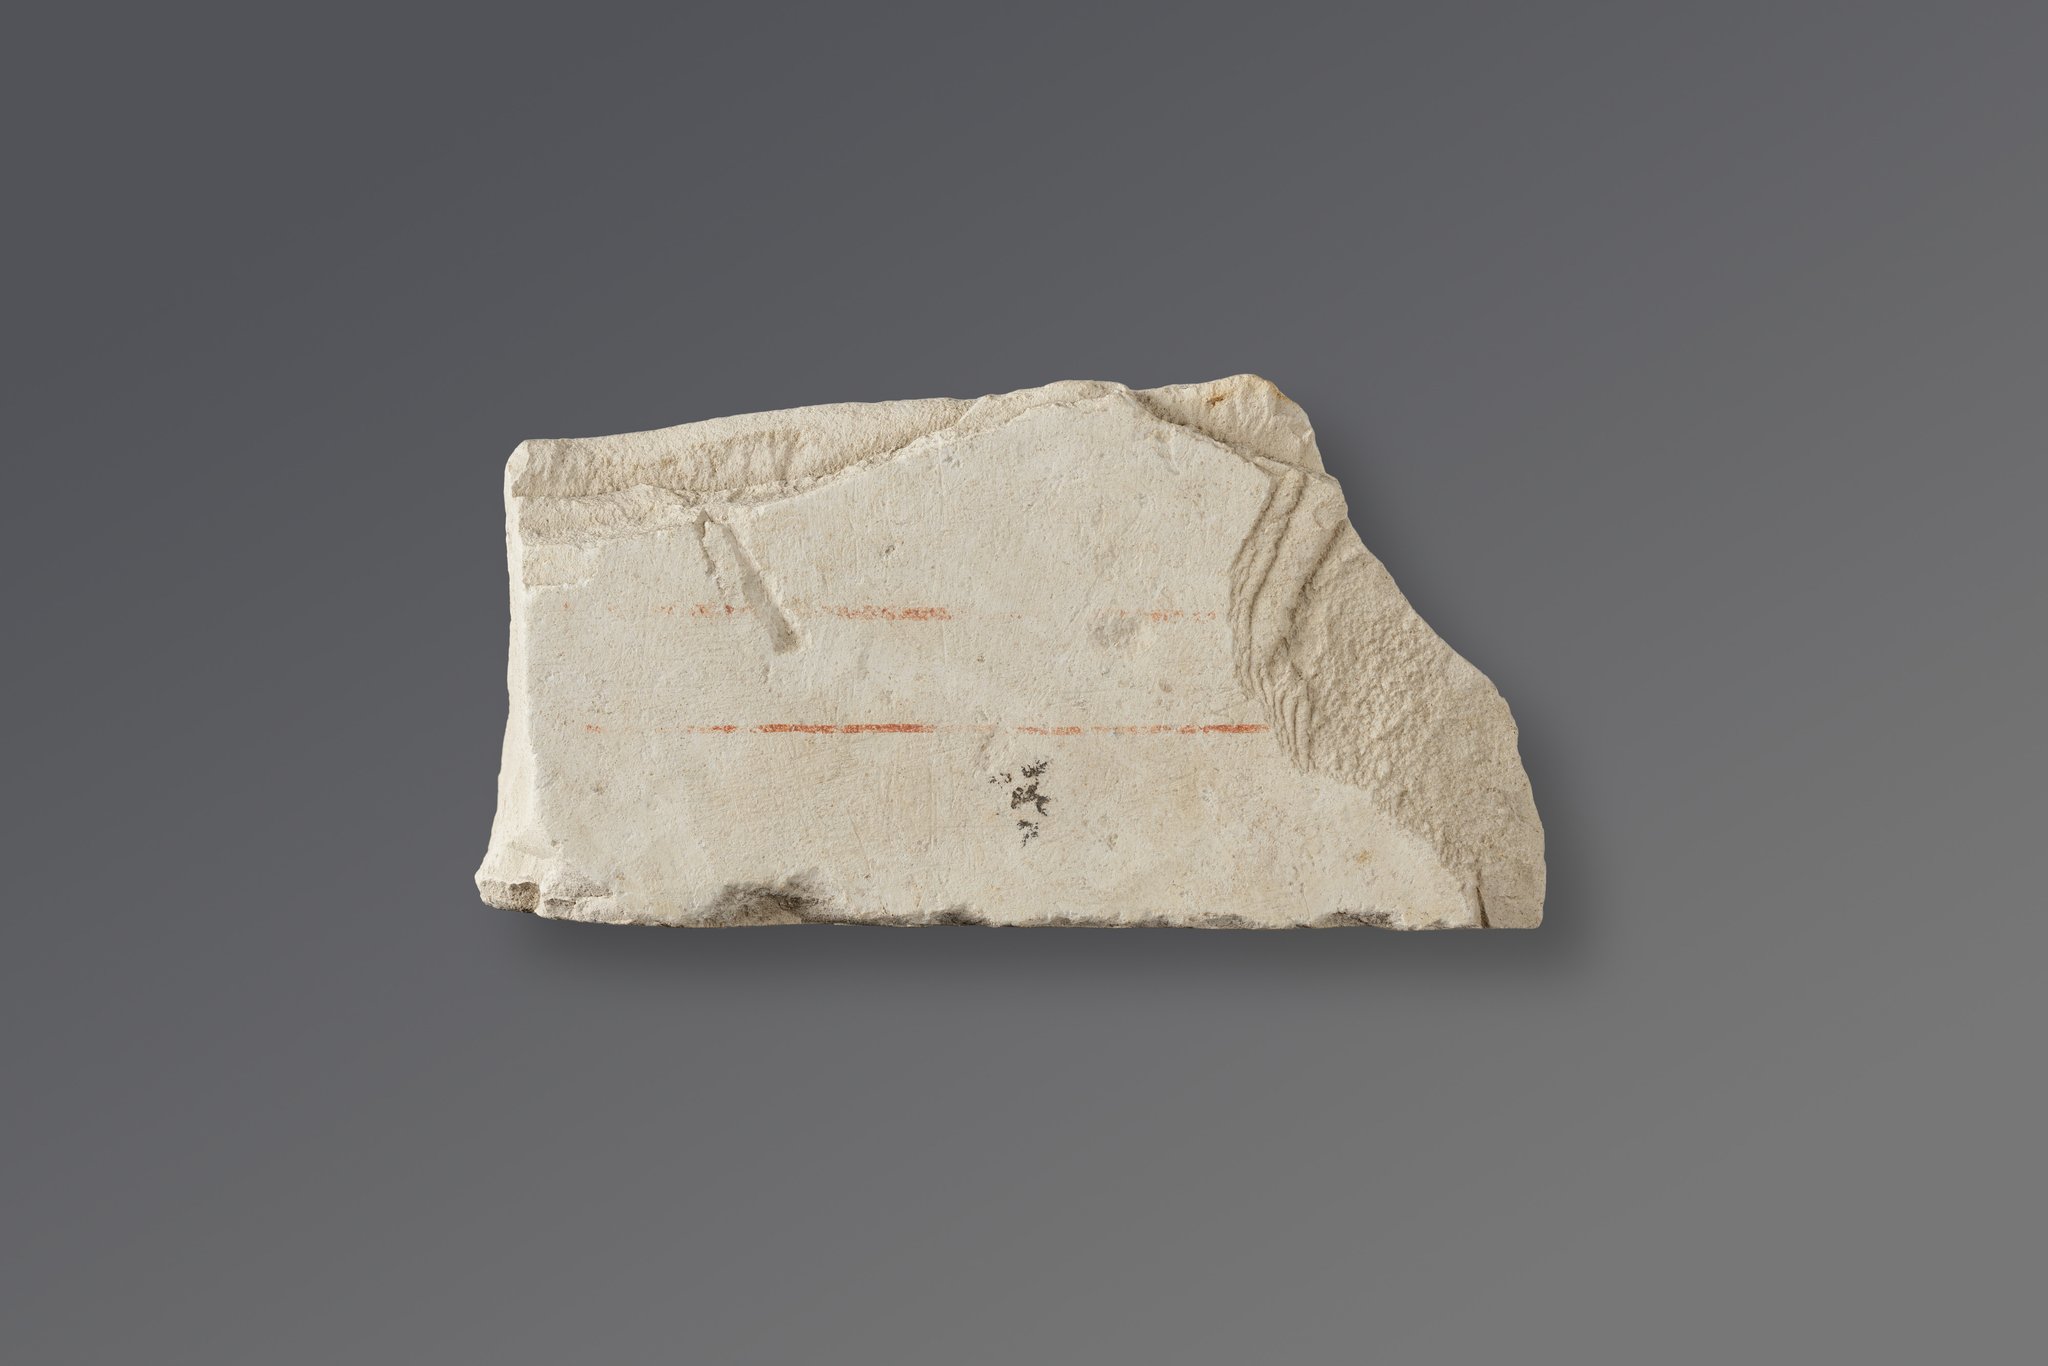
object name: relief drawing, sebeknakhte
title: Preliminary drawing for a relief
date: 2124-1504 BCE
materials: limestone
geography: egypt